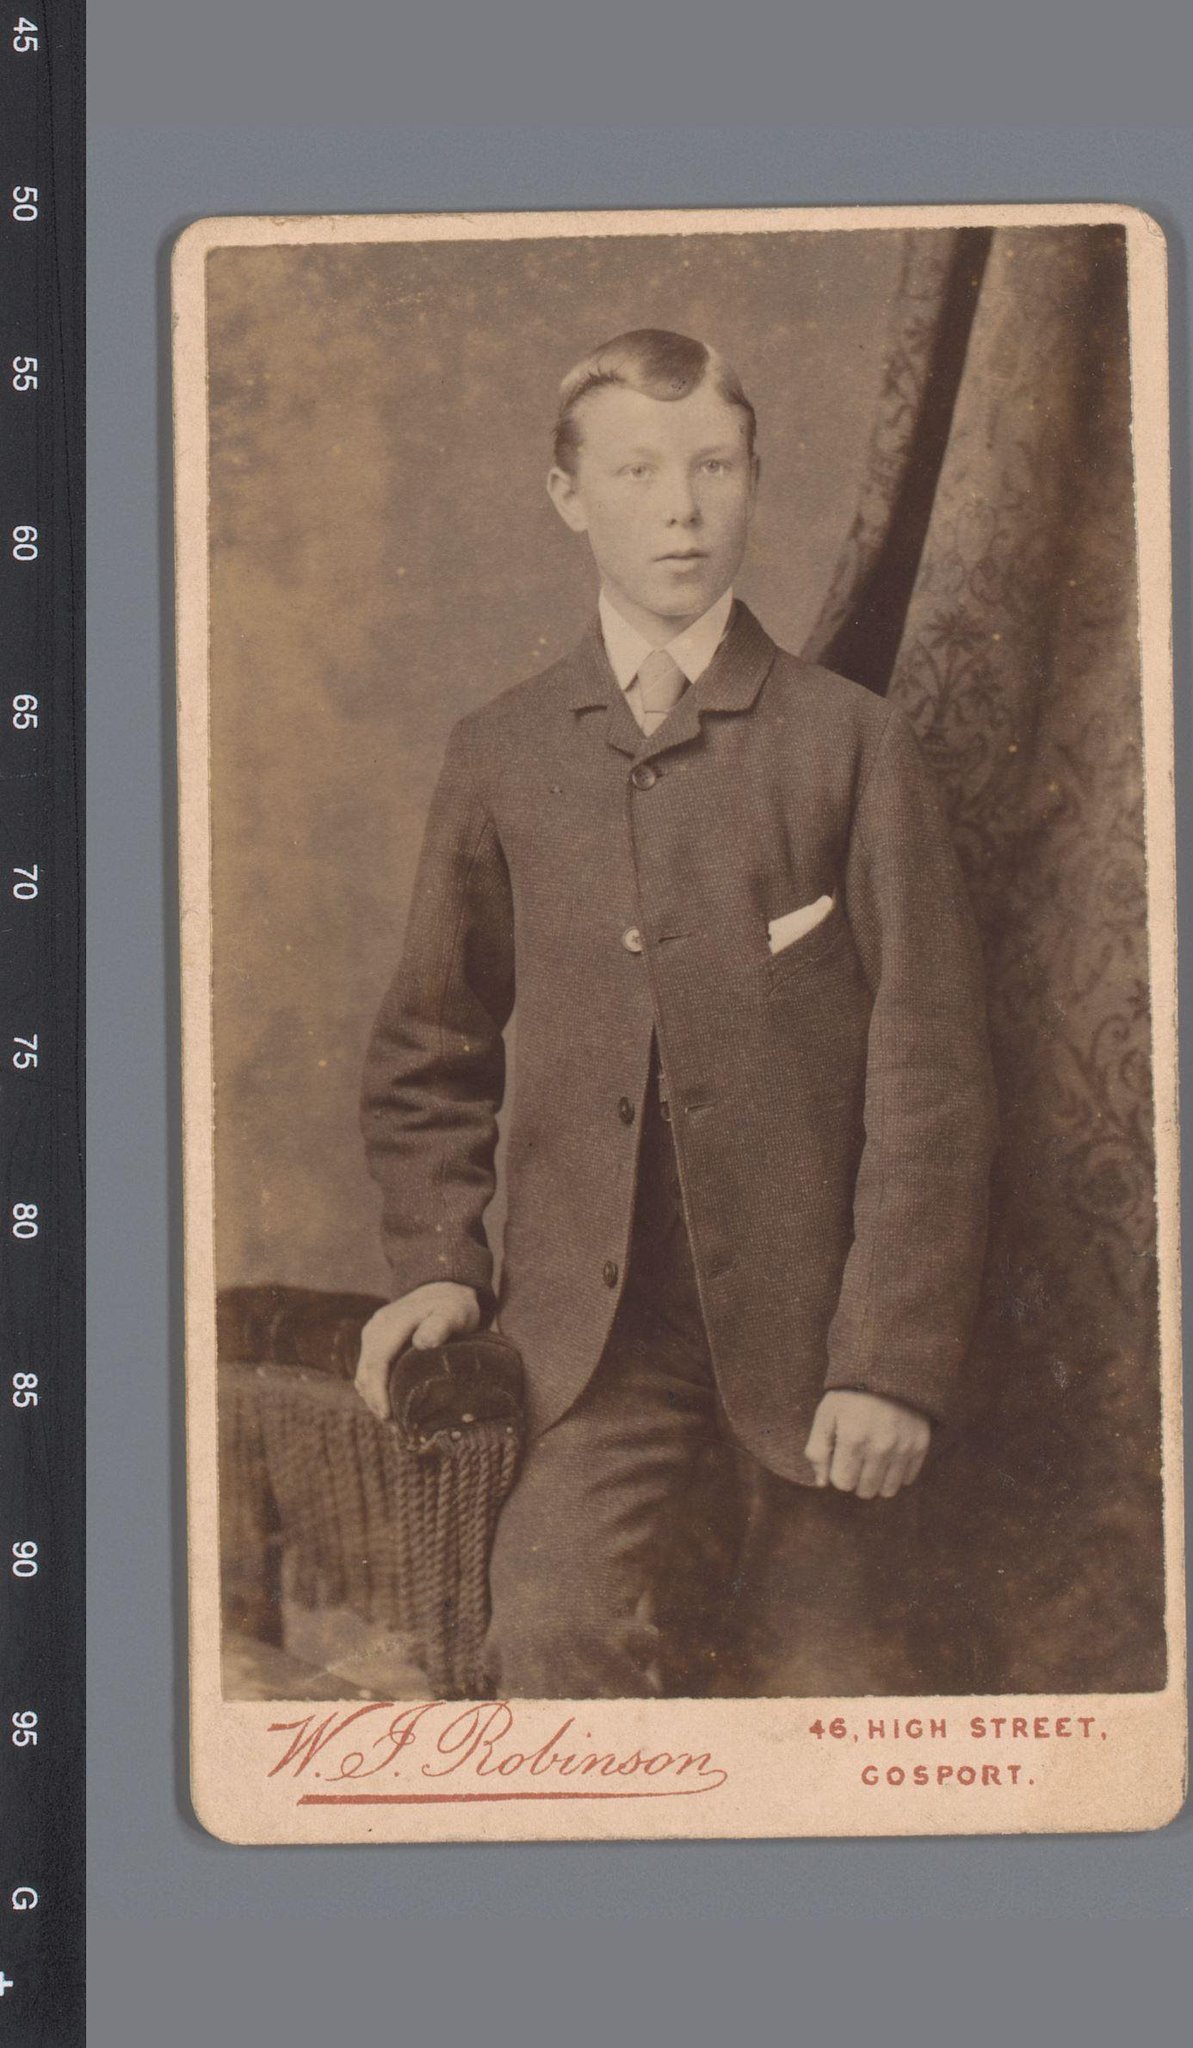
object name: carte de visite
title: Portret van William Heather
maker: w.j. robinson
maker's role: fotograaf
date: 1811-1885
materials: cardboard, paper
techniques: albumen print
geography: gosport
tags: historical persons, youth, adolescent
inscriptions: inscription: ‘William Heather Nov [...] 85/ age 17.’, number: ‘No 1355’, inscription: ‘The/ AMERICAN PHOTOGRAPHIC/ STUDIO/ 46, High Street/ GOSPORT/ also at 167, Commercial Road,/ Portsmouth LANDPORT./ This or any other Portrait enlarged &/ finished in any Style./ All negatives carefully preserved./ Copies can always be obtained/ by giving this number.’